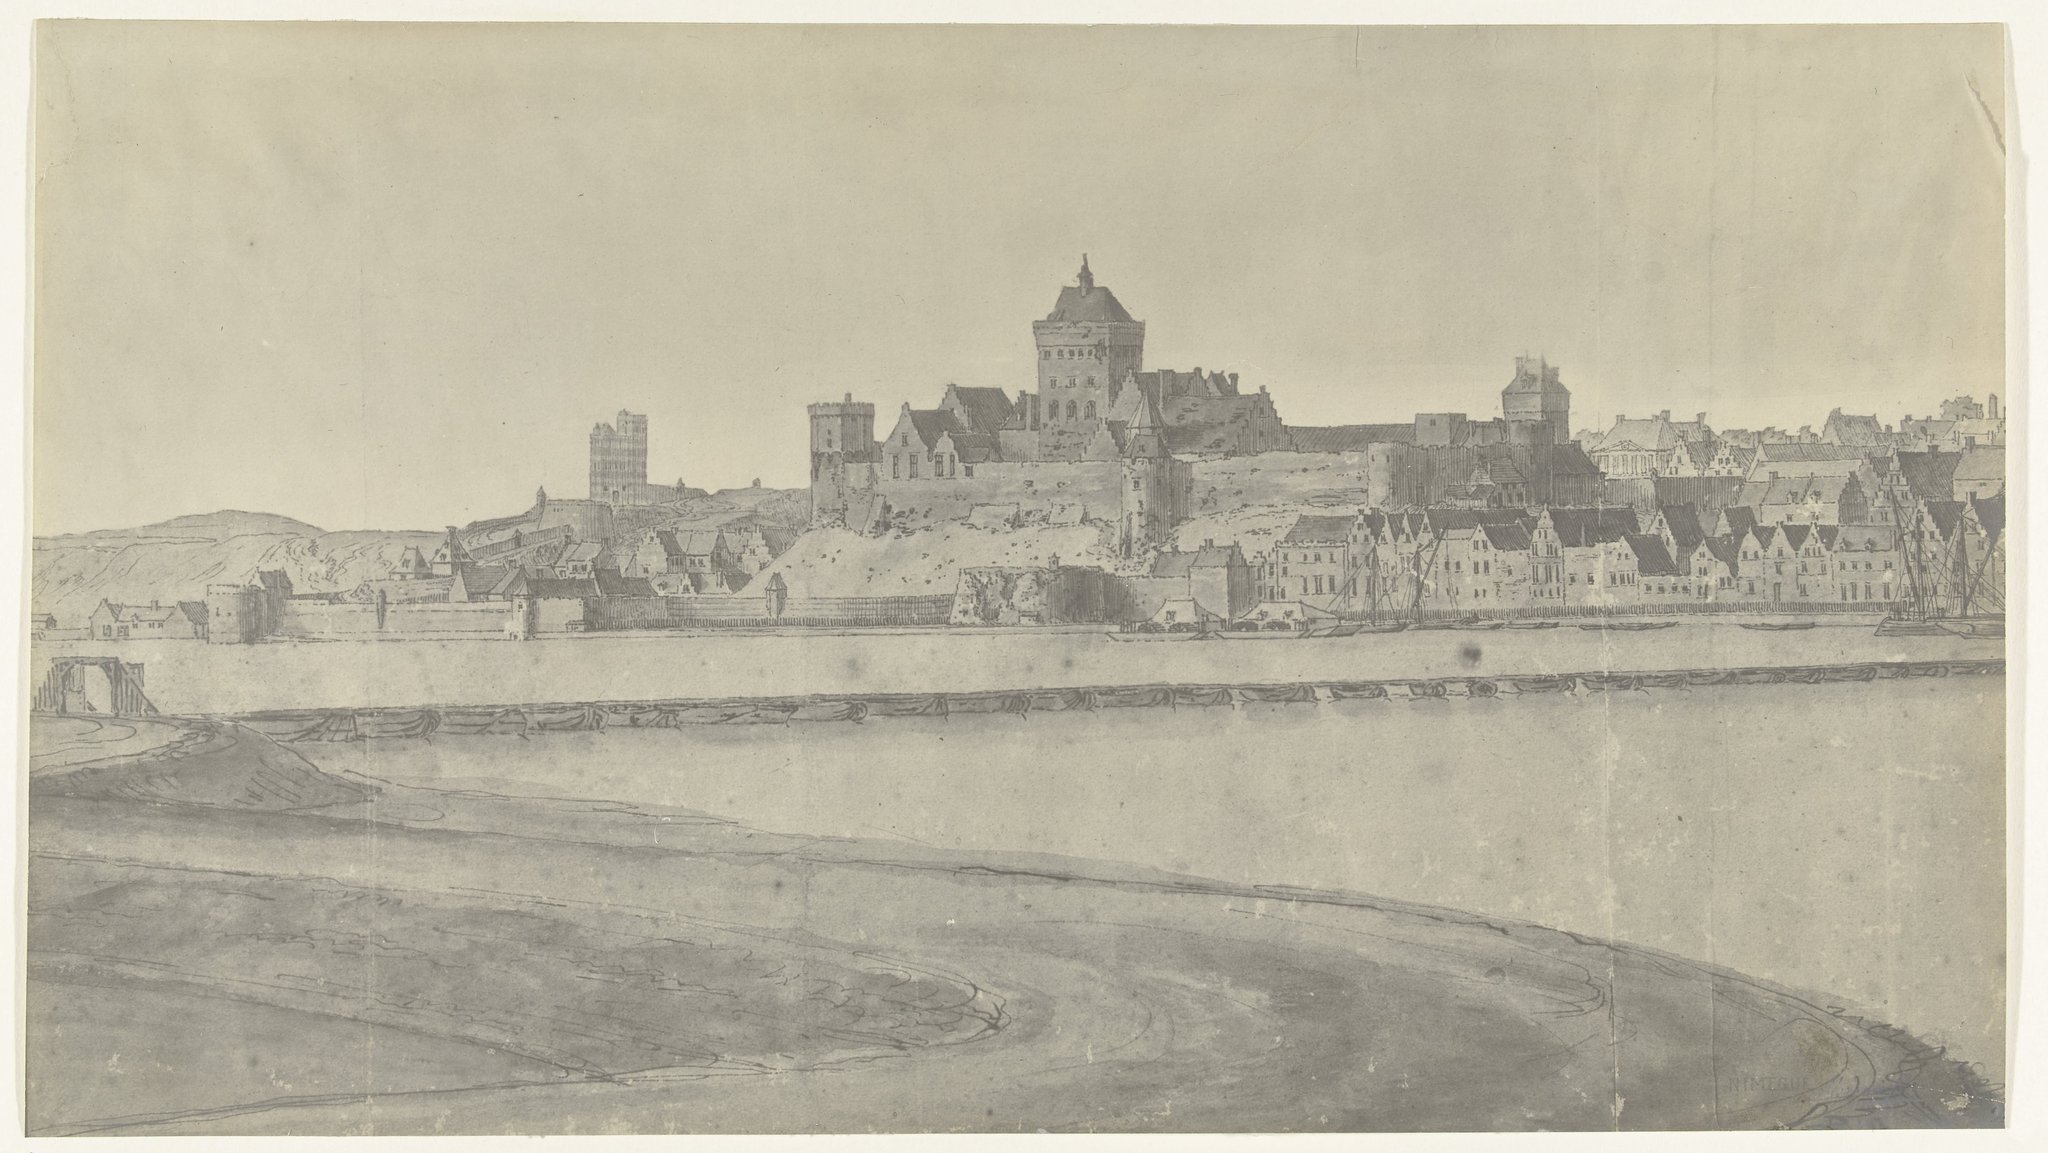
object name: photograph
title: Foto's van tekeningen van de Franse inval in de Nederlanden in 1672 door Adam Frans van der Meulen bewaard in de Manufacture des Gobelins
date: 1900-1903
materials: paper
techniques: gelatin silver print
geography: france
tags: lodewijk xiv (koning van frankrijk), city-view, and landscape with man-made constructions, nijmegen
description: Niet in Frederik Muller; door het RPK toegevoegd nummer. Onderdeel van een groep van ca. 50 foto's van tekeningen van de Franse inval in de Nederlanden in 1672 door Adam Frans van der Meulen, bewaard in de Manufacture Nationale des Gobelins te Parijs.